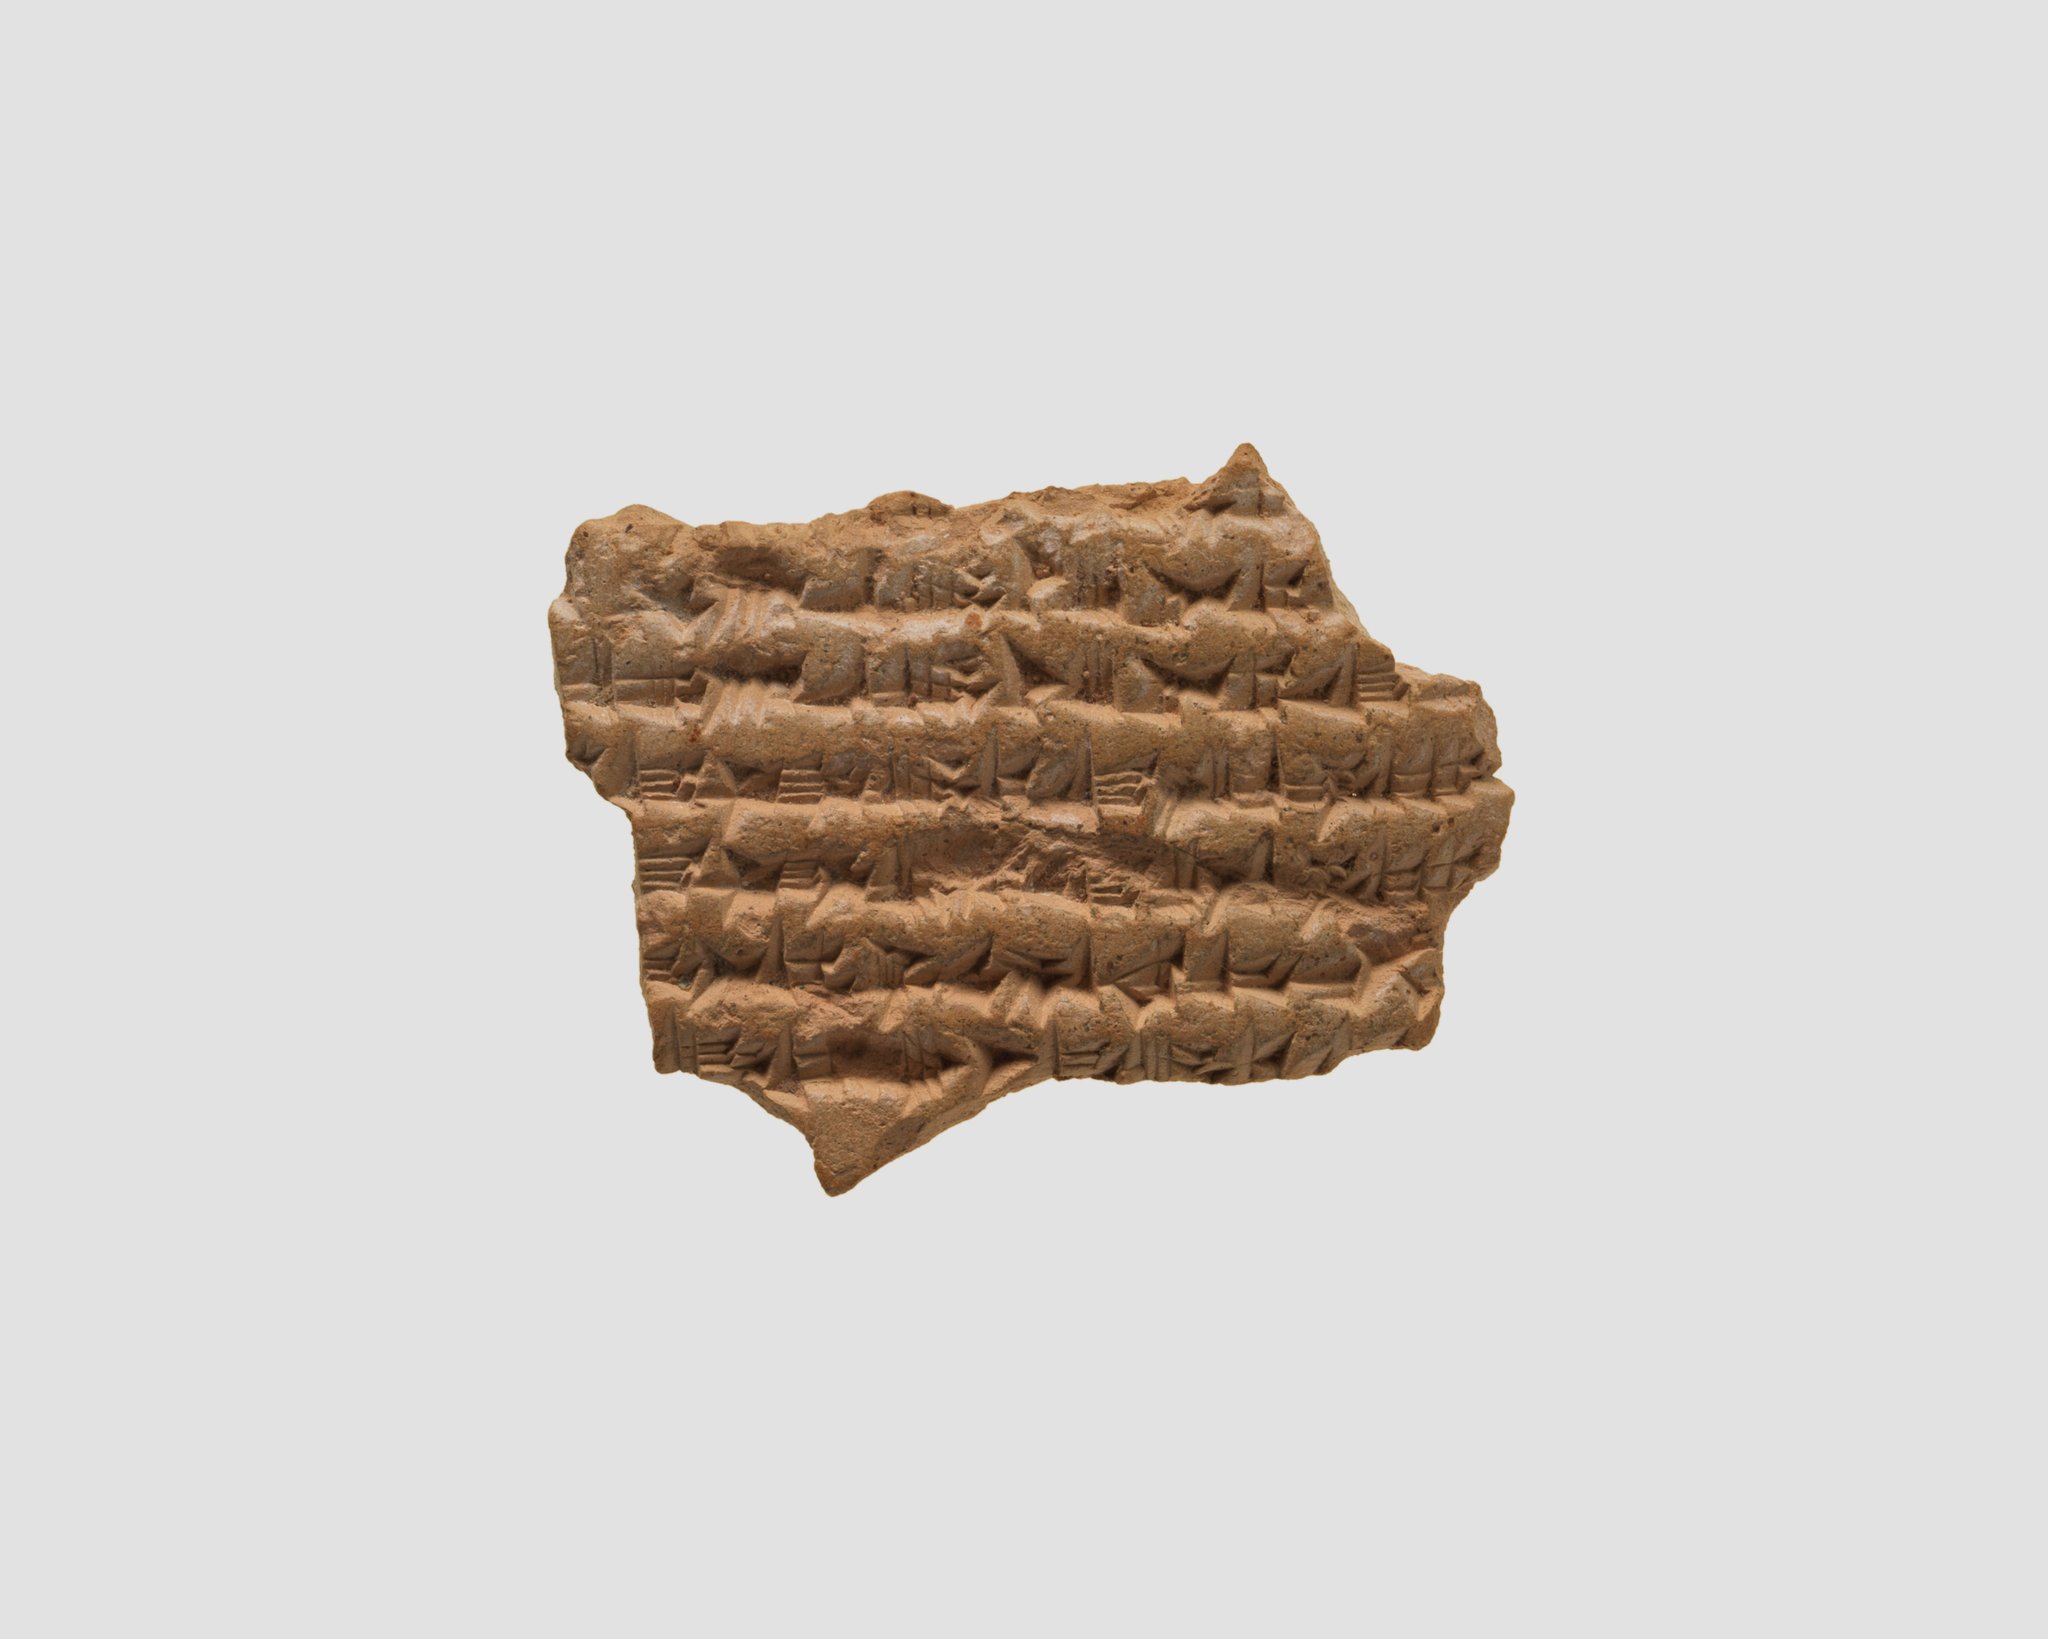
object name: cuneiform tablet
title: Cuneiform tablet: fragment of a liver omen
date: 333-1 BCE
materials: clay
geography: mesopotamia